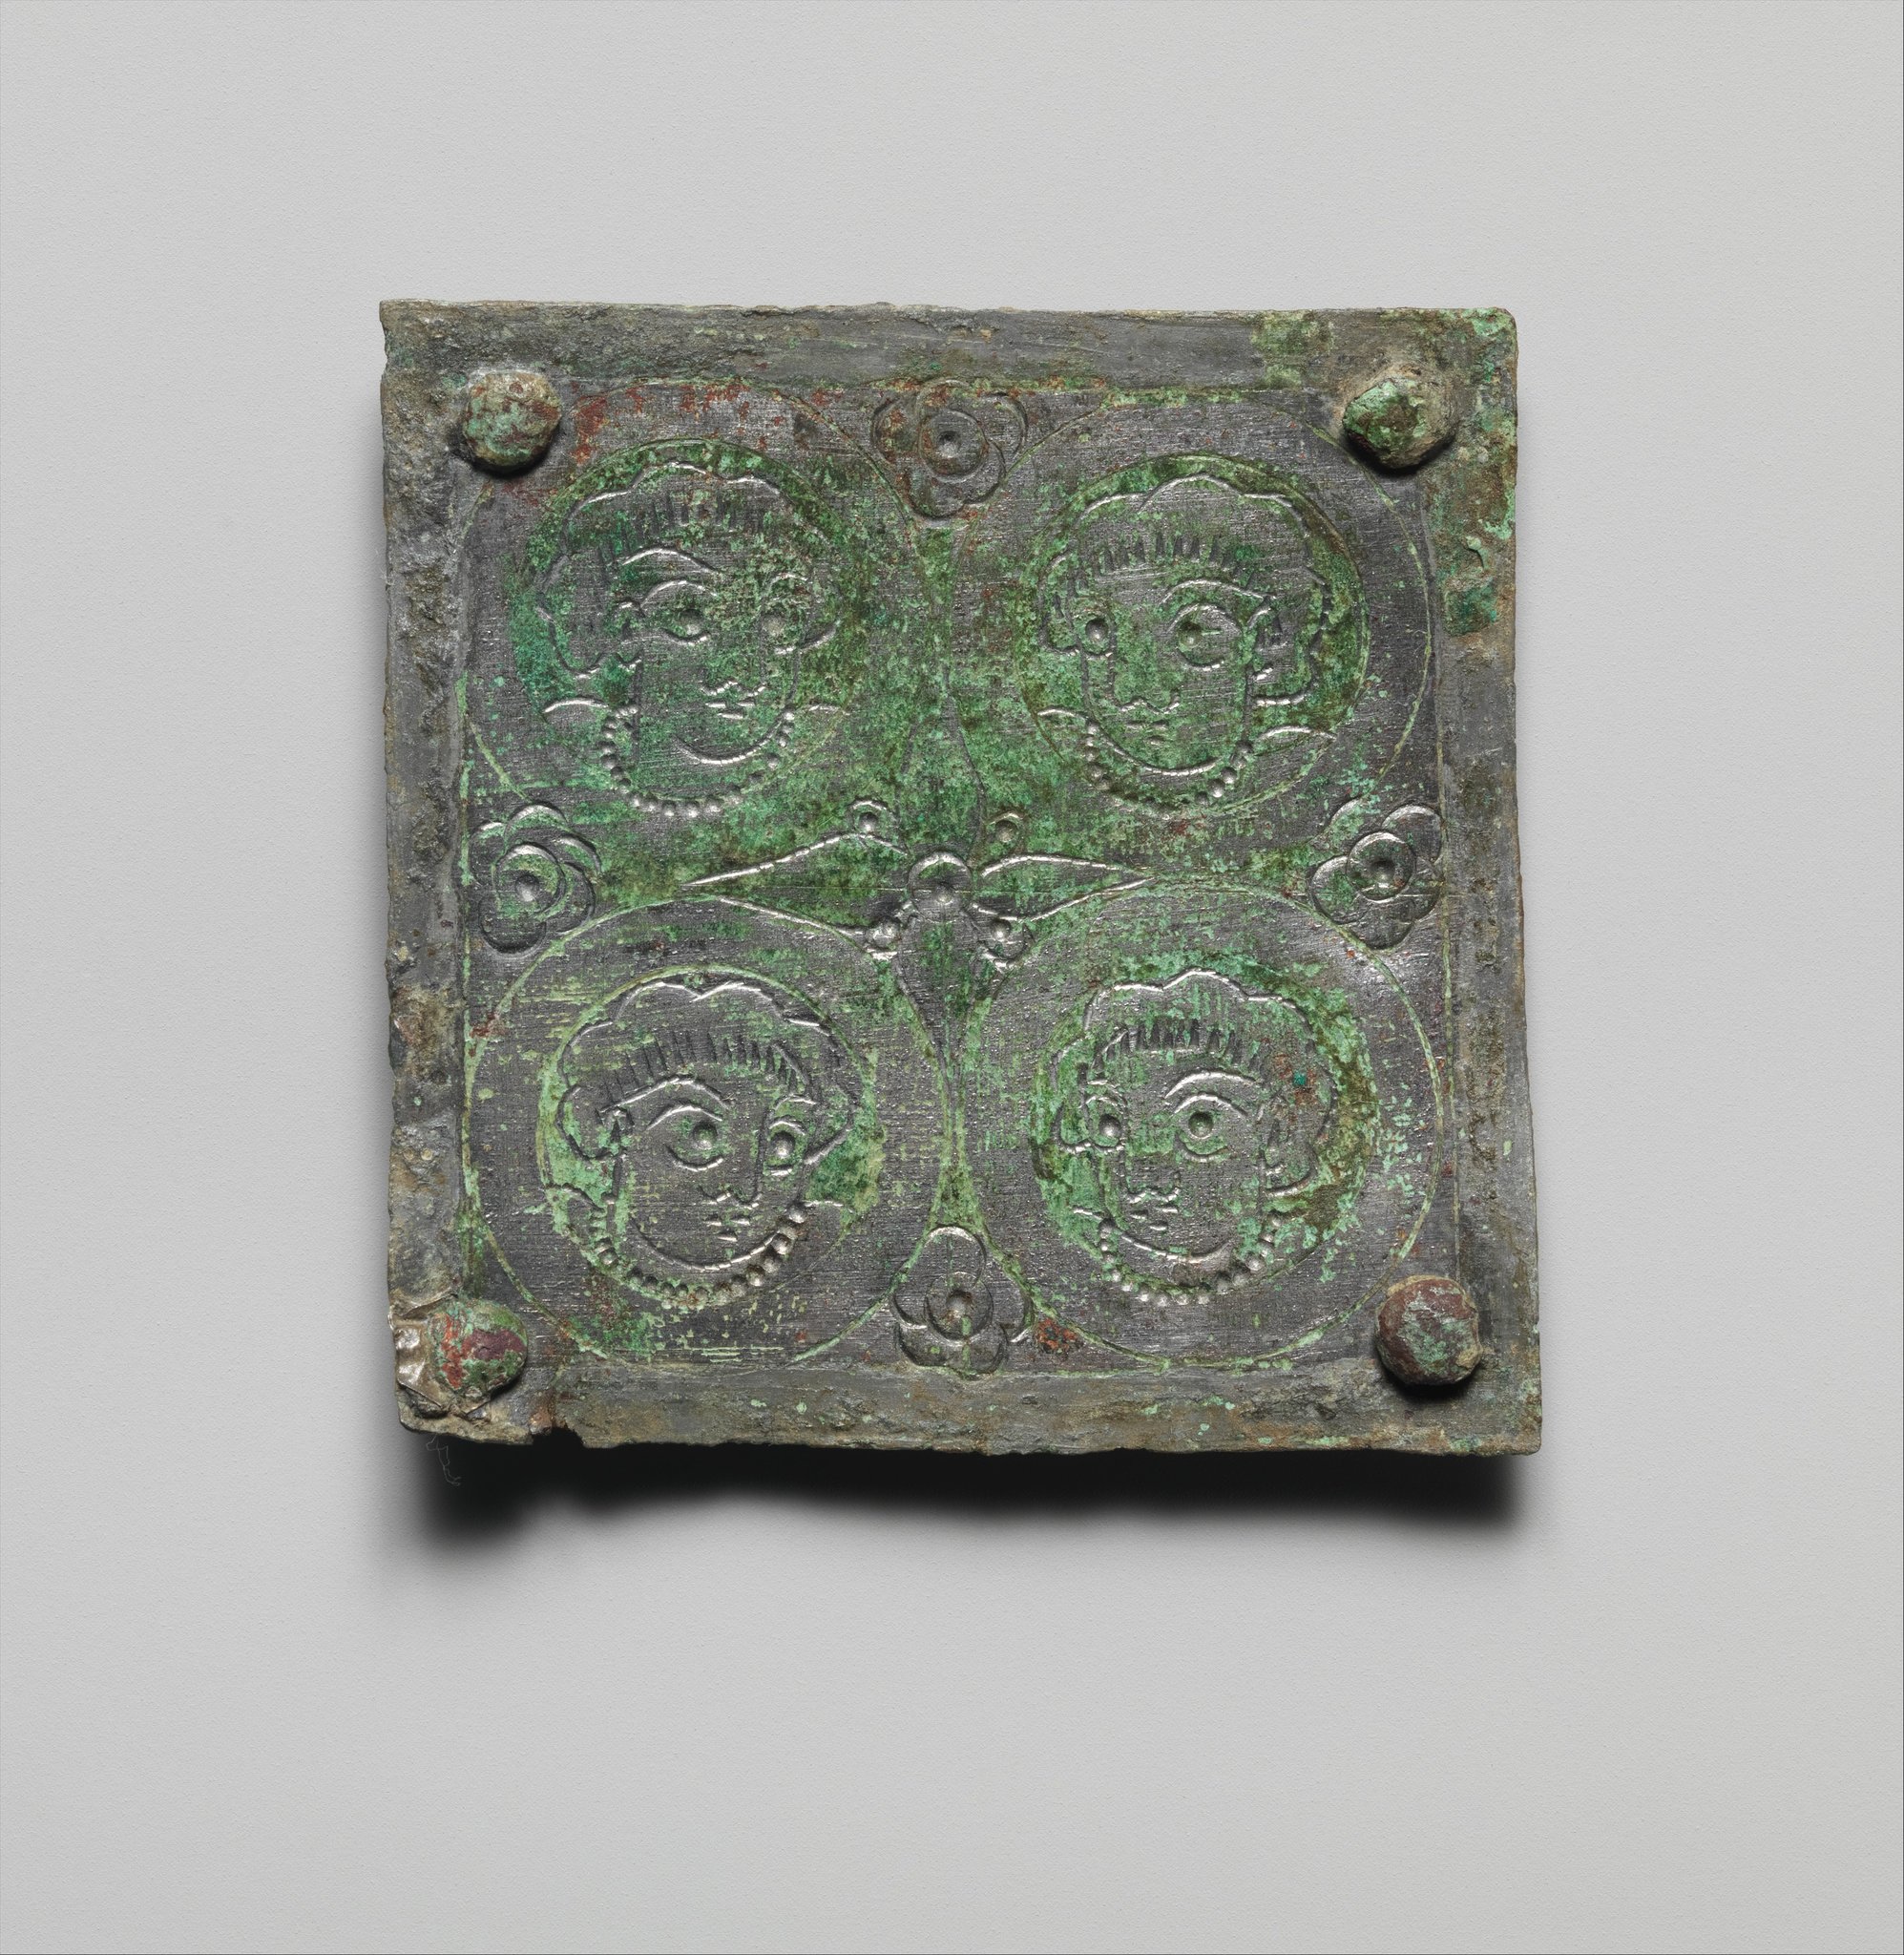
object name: plaque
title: Tinned-Copper Plaque with a Personification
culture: byzantine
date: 350-400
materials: copper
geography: italy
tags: human figures